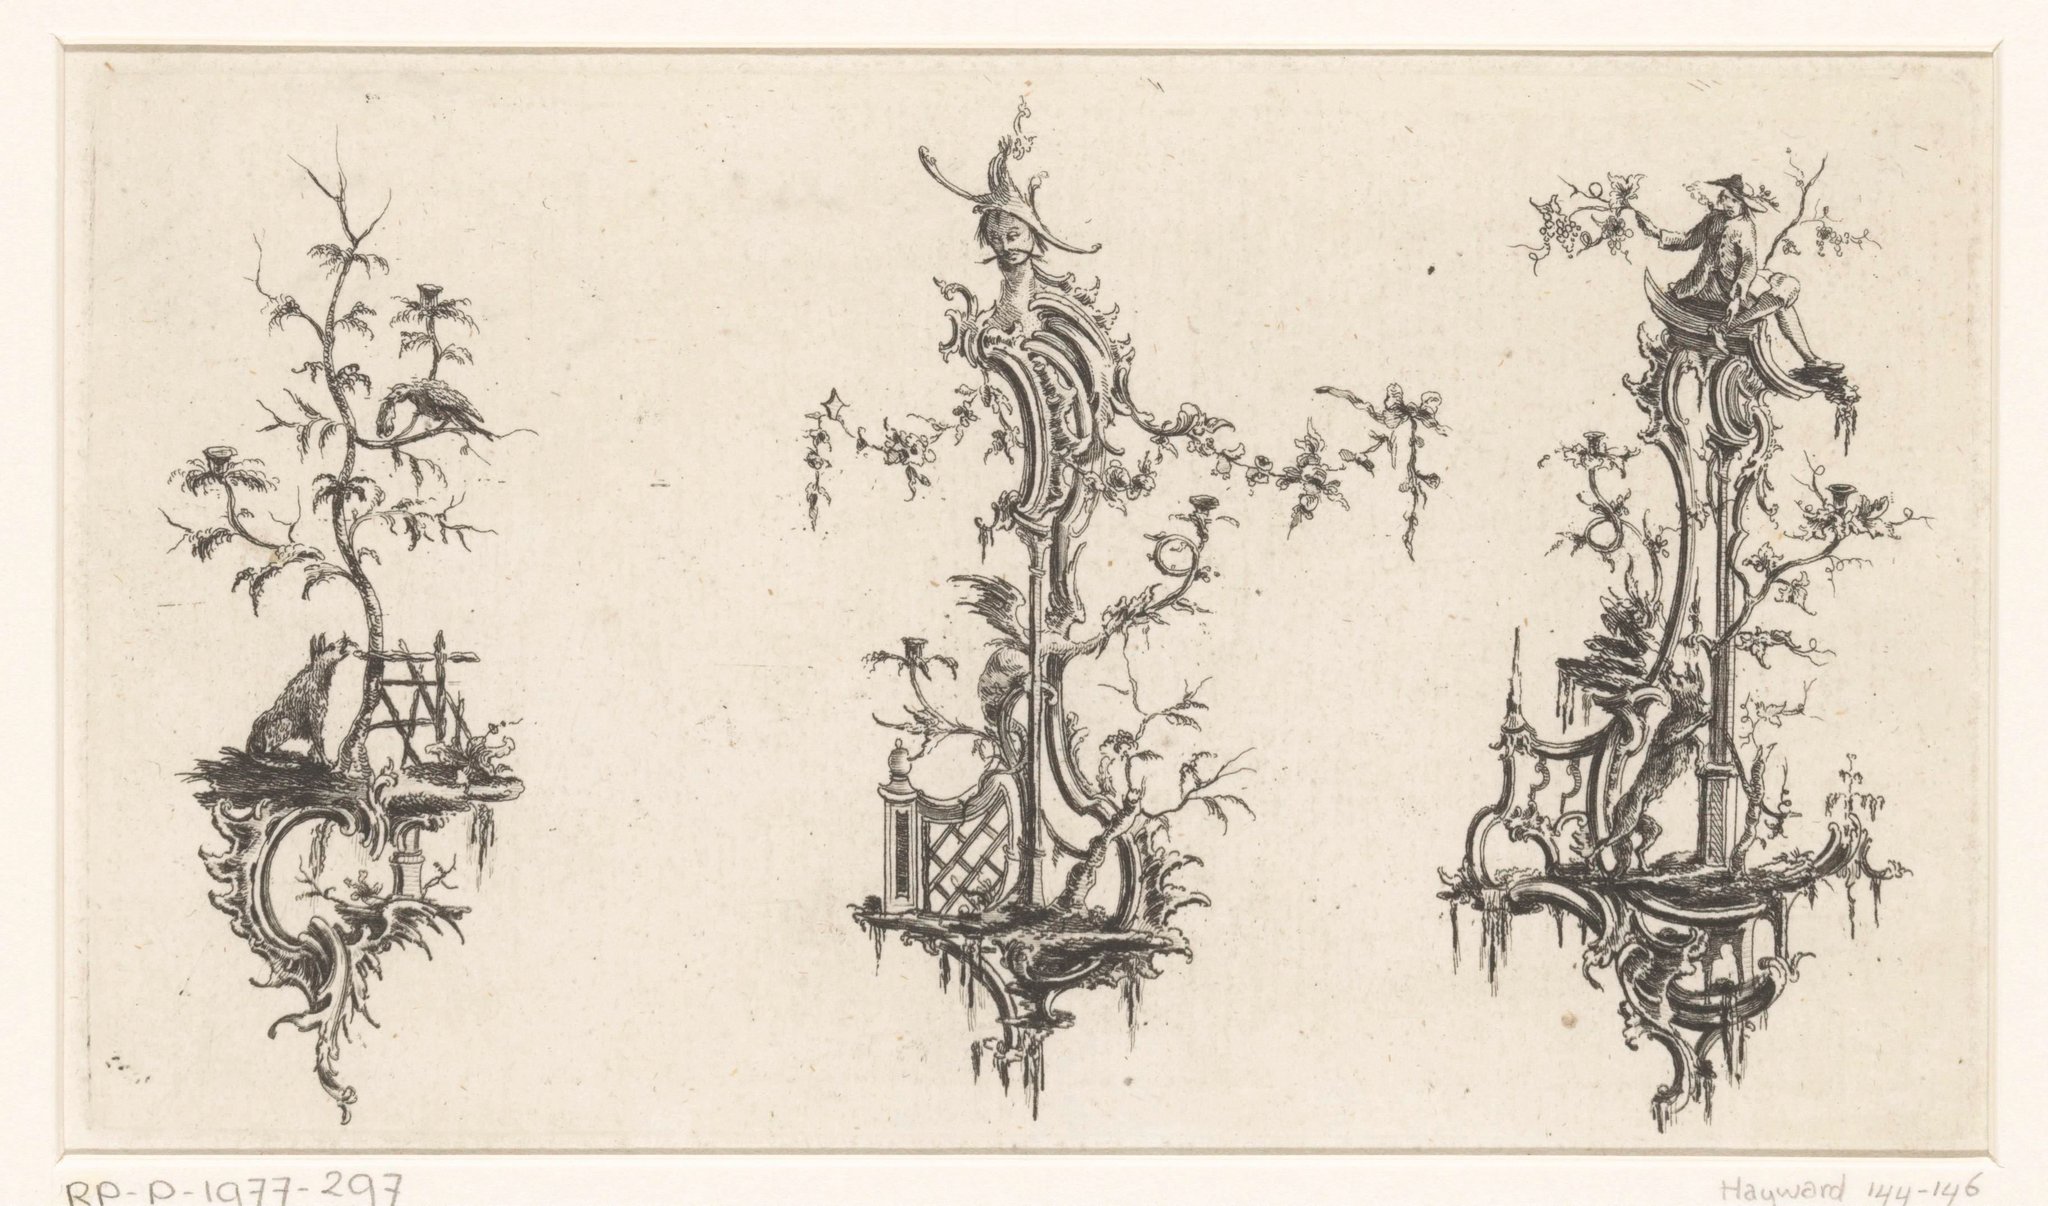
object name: ornament print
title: Drie girandoles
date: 1755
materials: paper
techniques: engraving, etching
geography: london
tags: chandelier, candelabrum, dragon, beasts of prey, predatory animals: wolf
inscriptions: collector's mark: Lugt 2228, collector's mark: Lugt 2760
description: Drie geornamenteerde girandoles. Links met een wolf en een vogel. In het midden met een draak en bekroond met een oosters uitziende mannenbuste. Rechts met een wolf en bekroond met een zittende figuur.